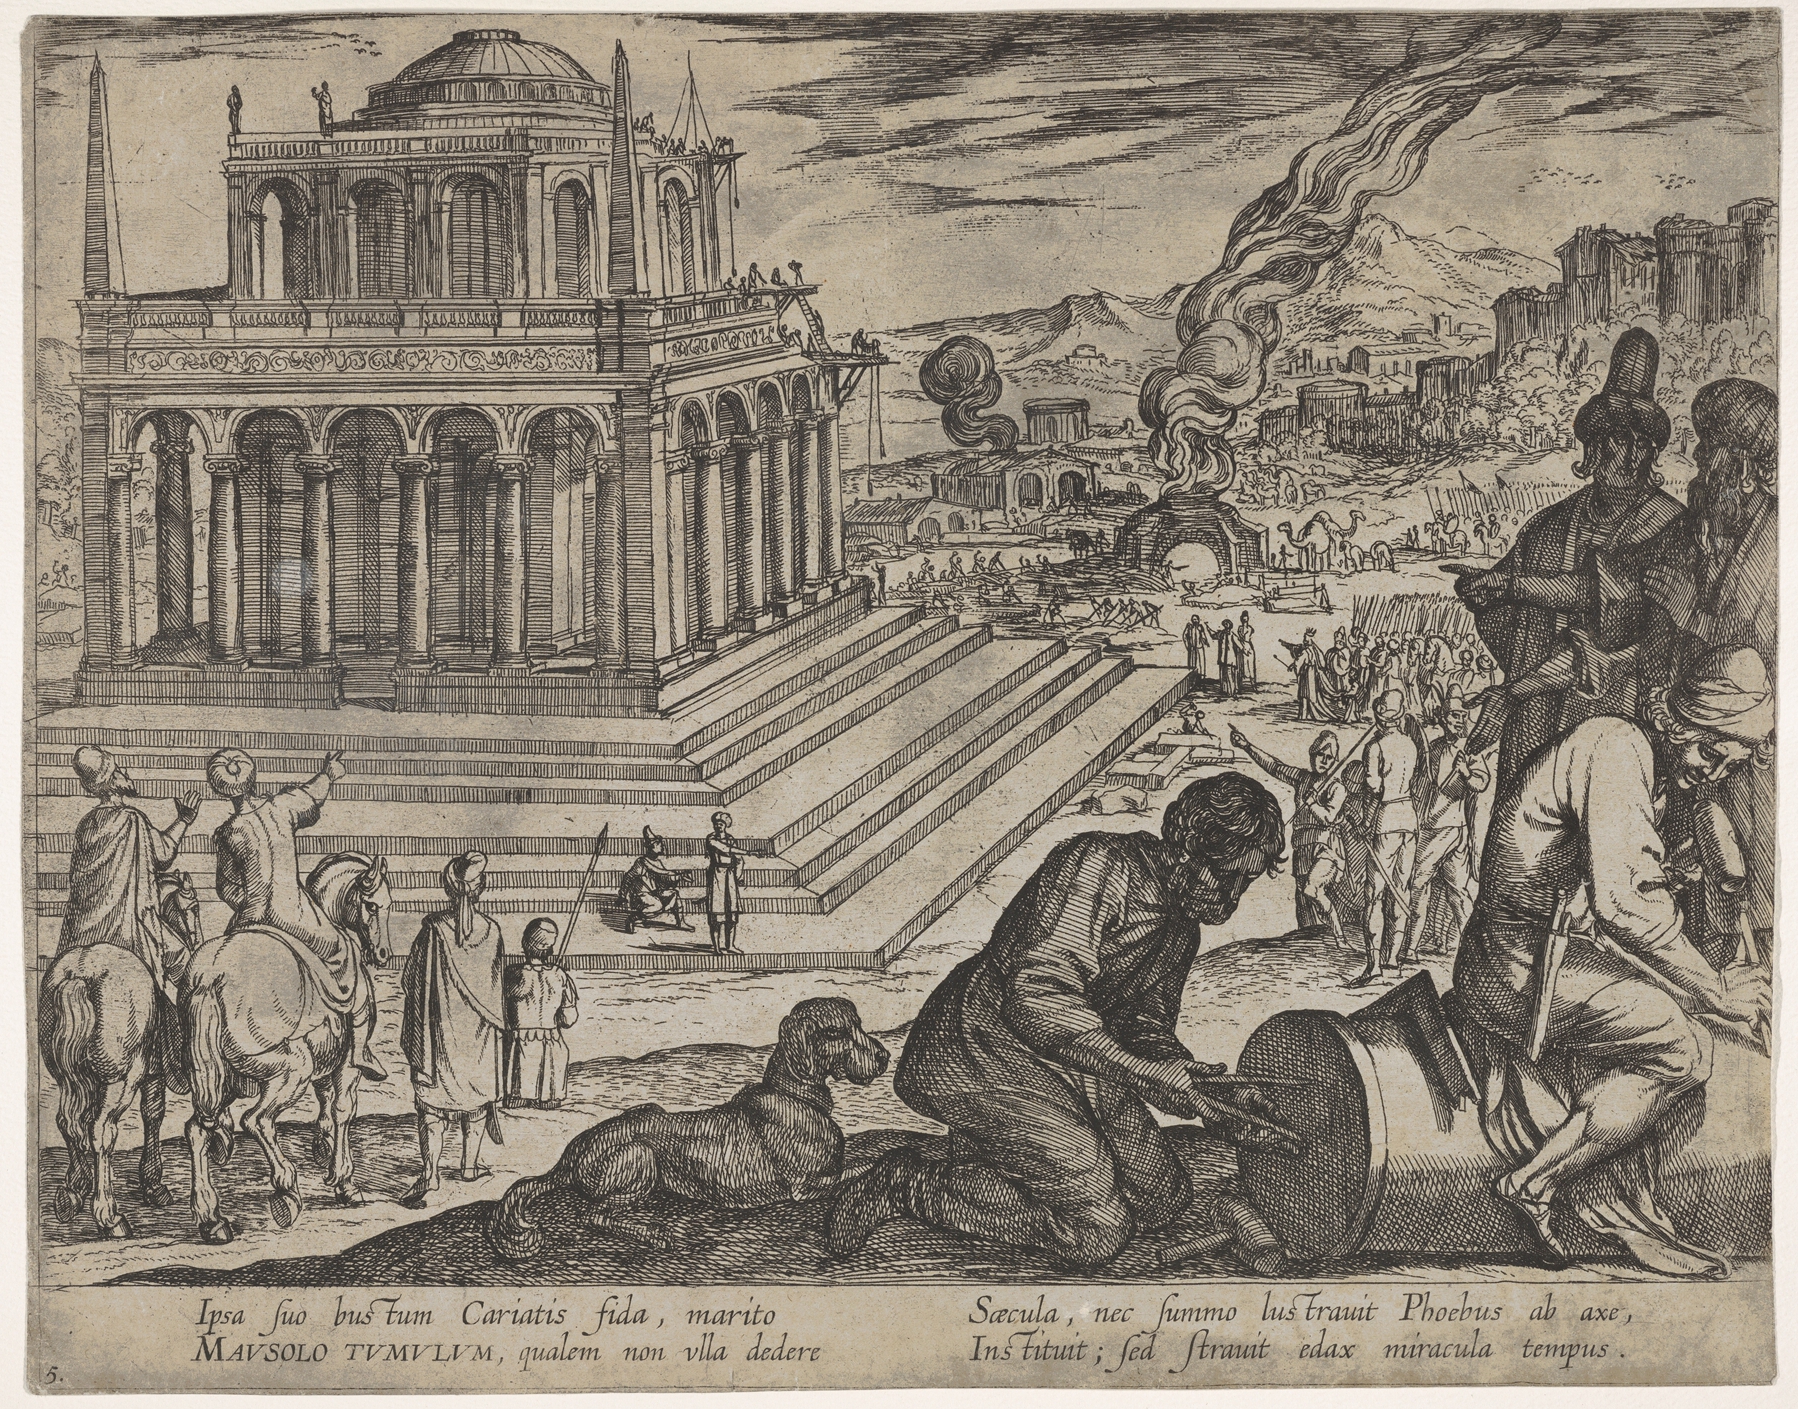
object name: print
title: Plate 5: Tomb of Mausolus, stone masons make a column at the right, from "The Seven Wonders of the World"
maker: antonio tempesta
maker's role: artist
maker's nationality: italian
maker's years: 1555-1630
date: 1608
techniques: etching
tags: tombs,men,dogs,horses